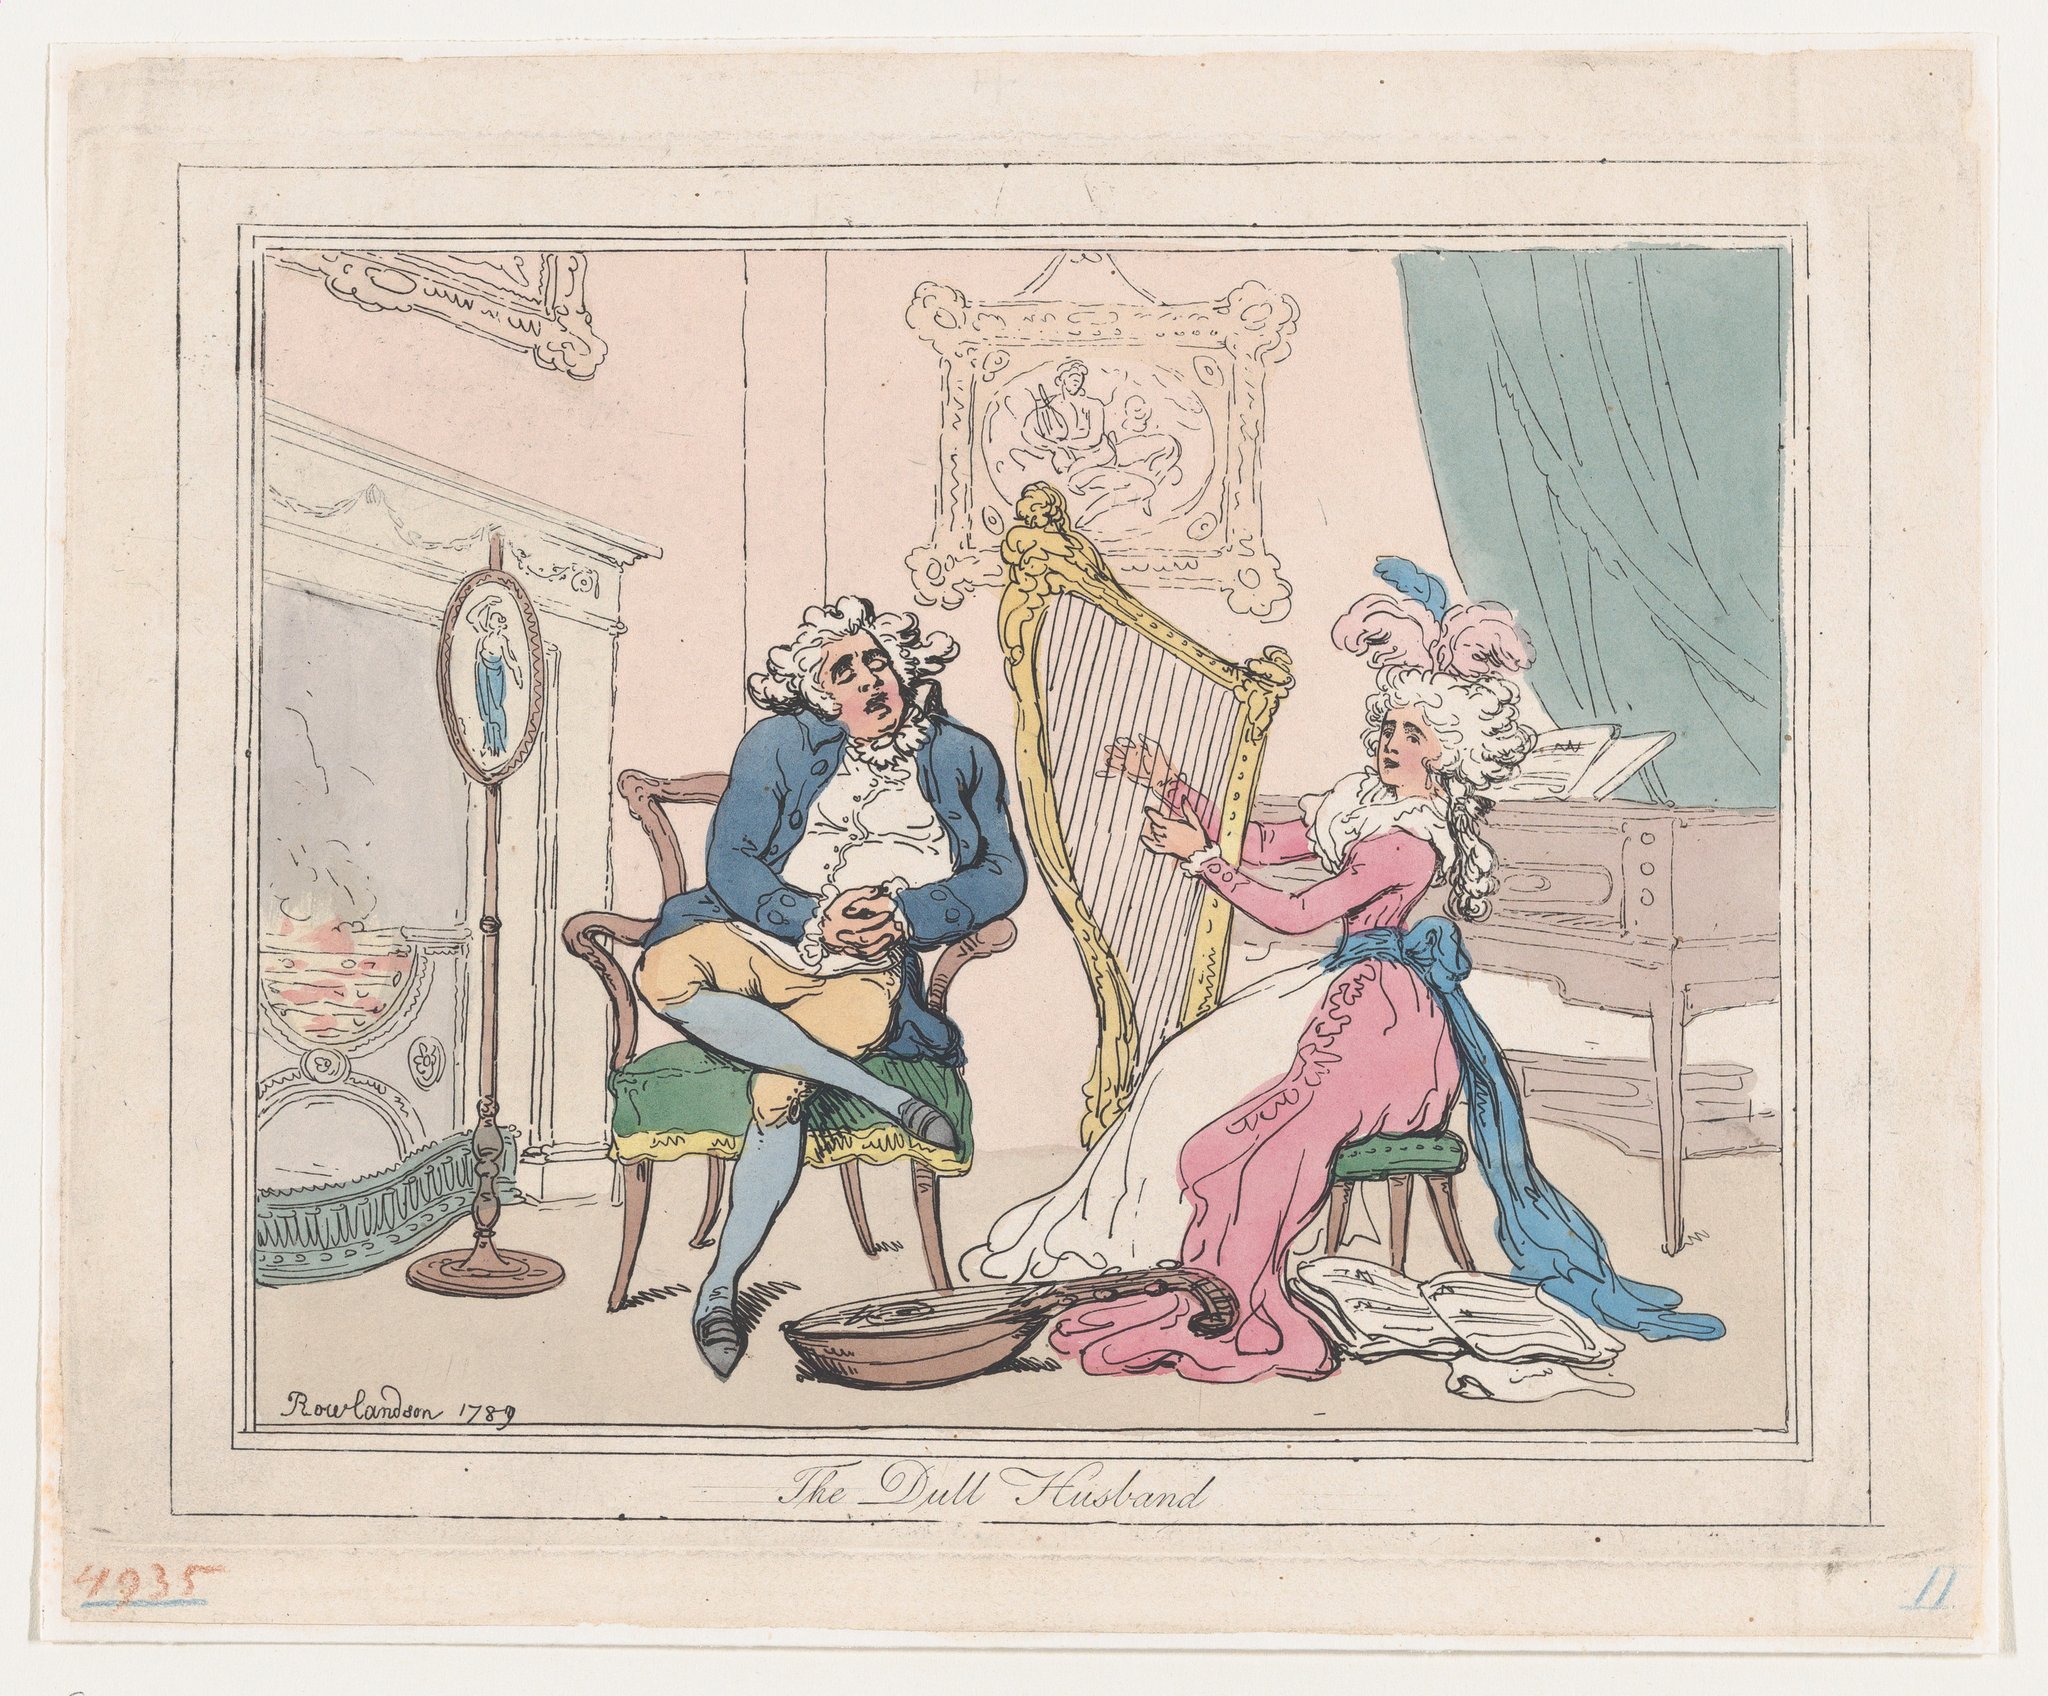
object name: print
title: The Dull Husband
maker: thomas rowlandson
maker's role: artist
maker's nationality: british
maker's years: 1757-1827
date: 1789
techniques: aquatint, etching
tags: men,women,harps